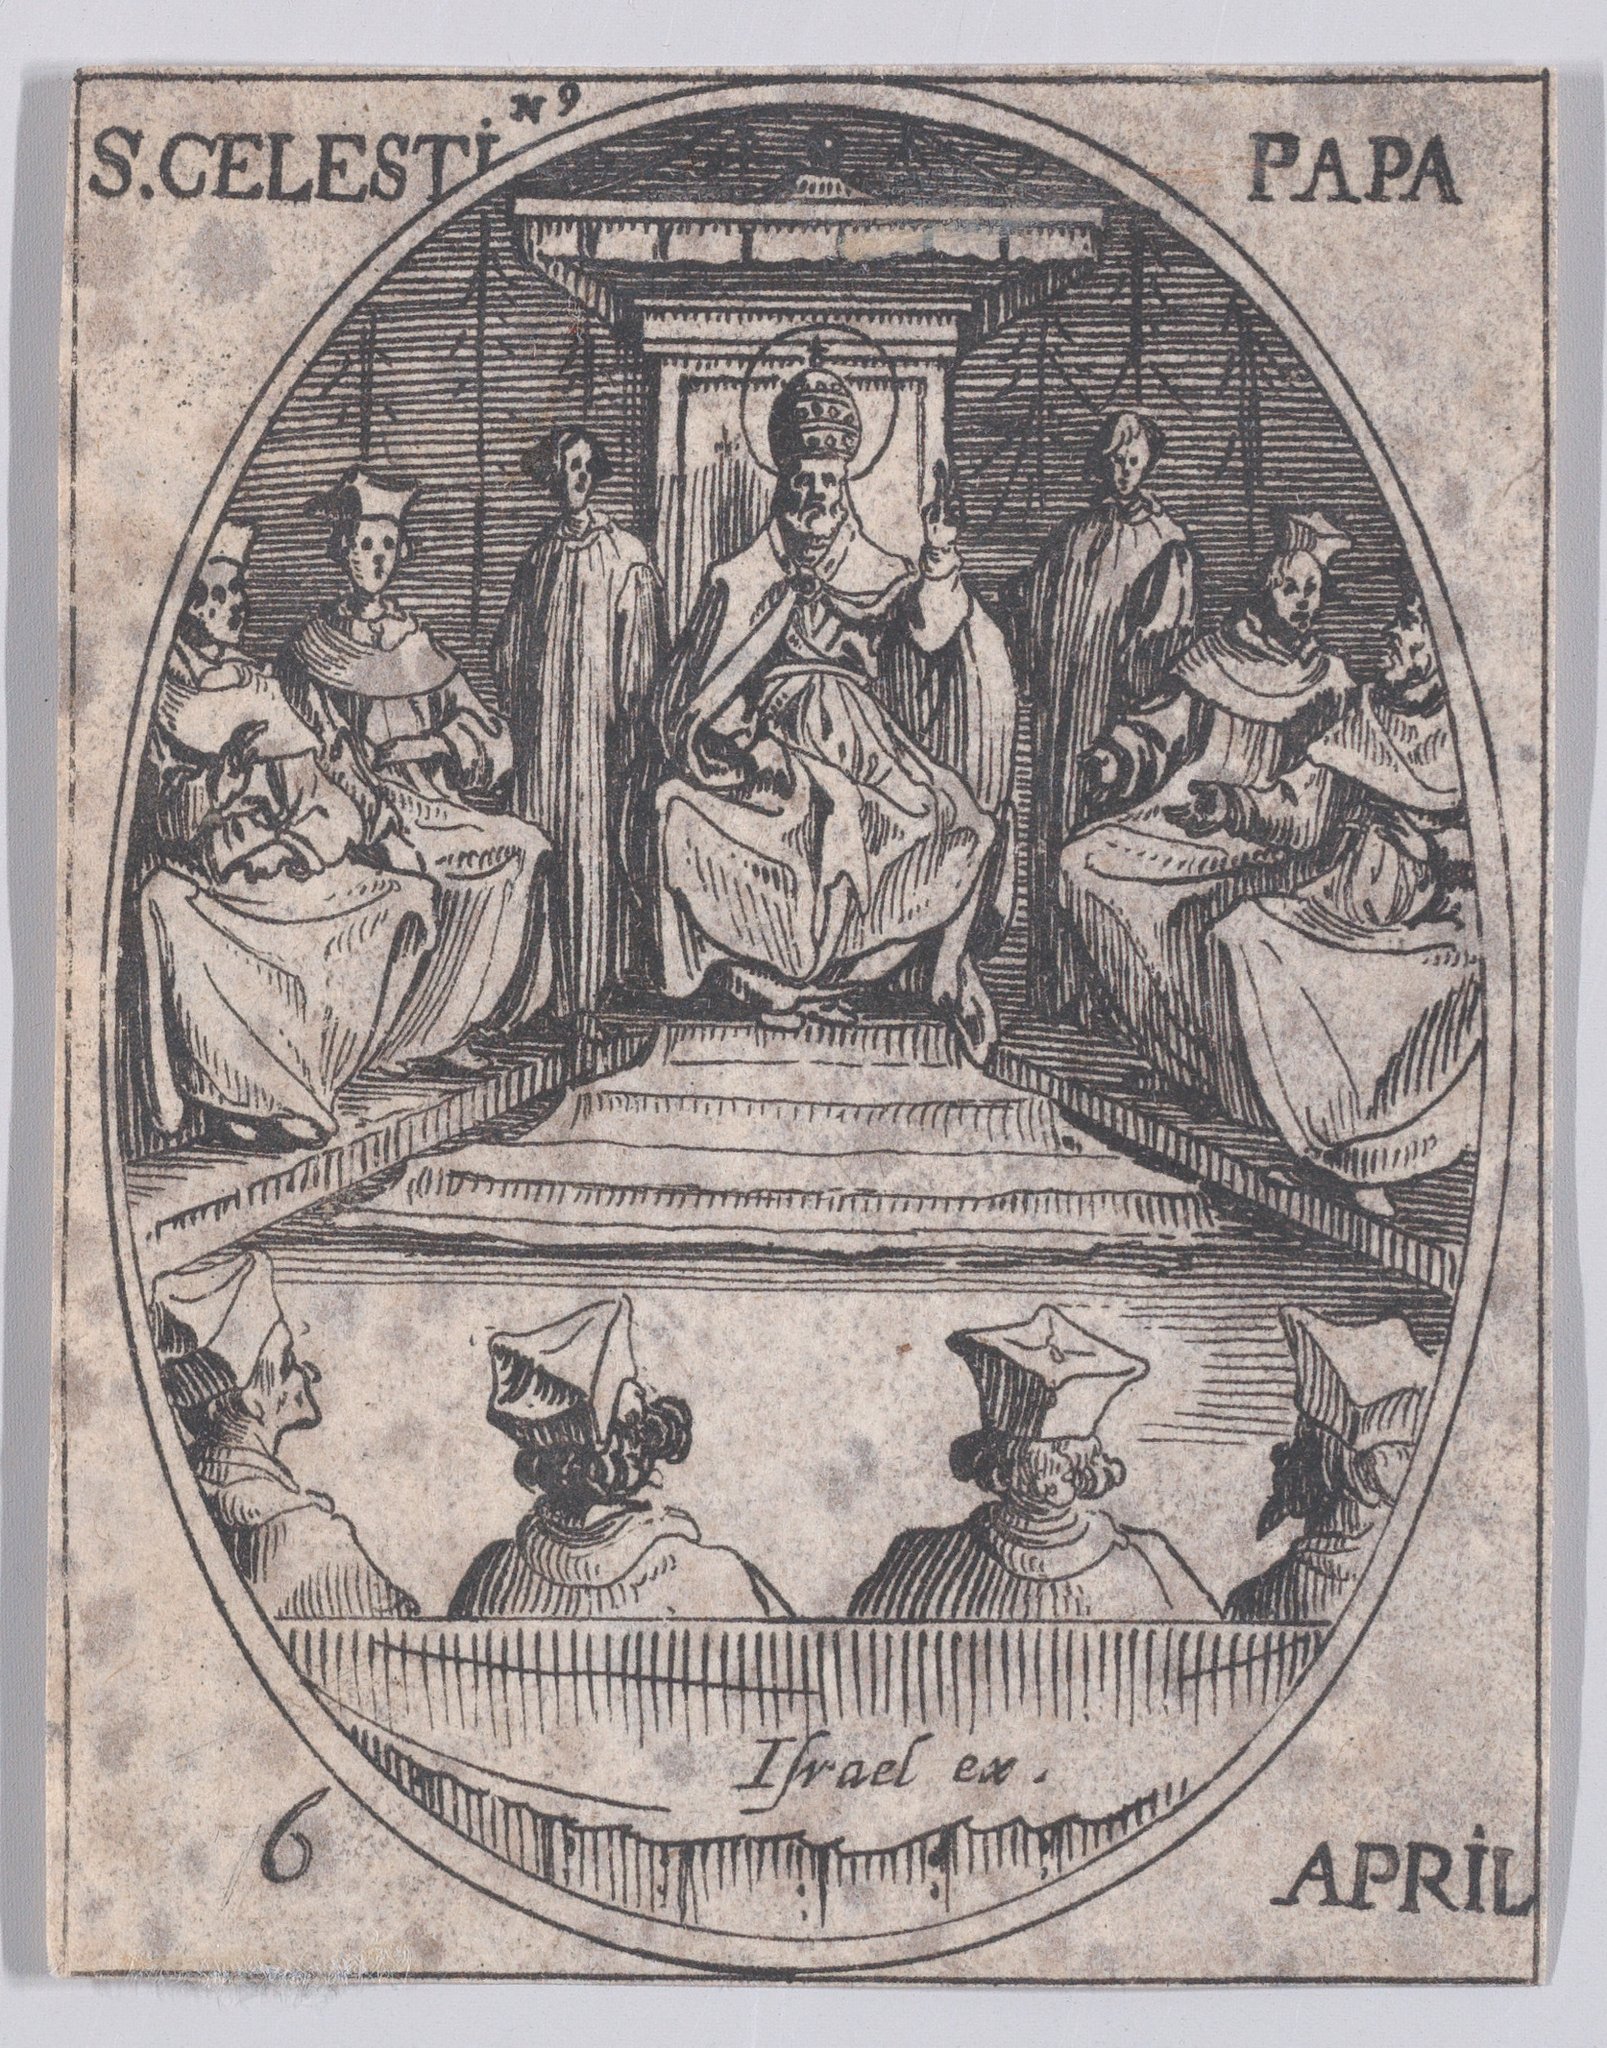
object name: print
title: S. Célestin, pape (St. Celestine, Pope), April 6th, from "Les Images De Tous Les Saincts et Saintes de L'Année" (Images of All of the Saints and Religious Events of the Year)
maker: jacques callot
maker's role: artist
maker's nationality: french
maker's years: 1592-1635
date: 1636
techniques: etching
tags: men,saints